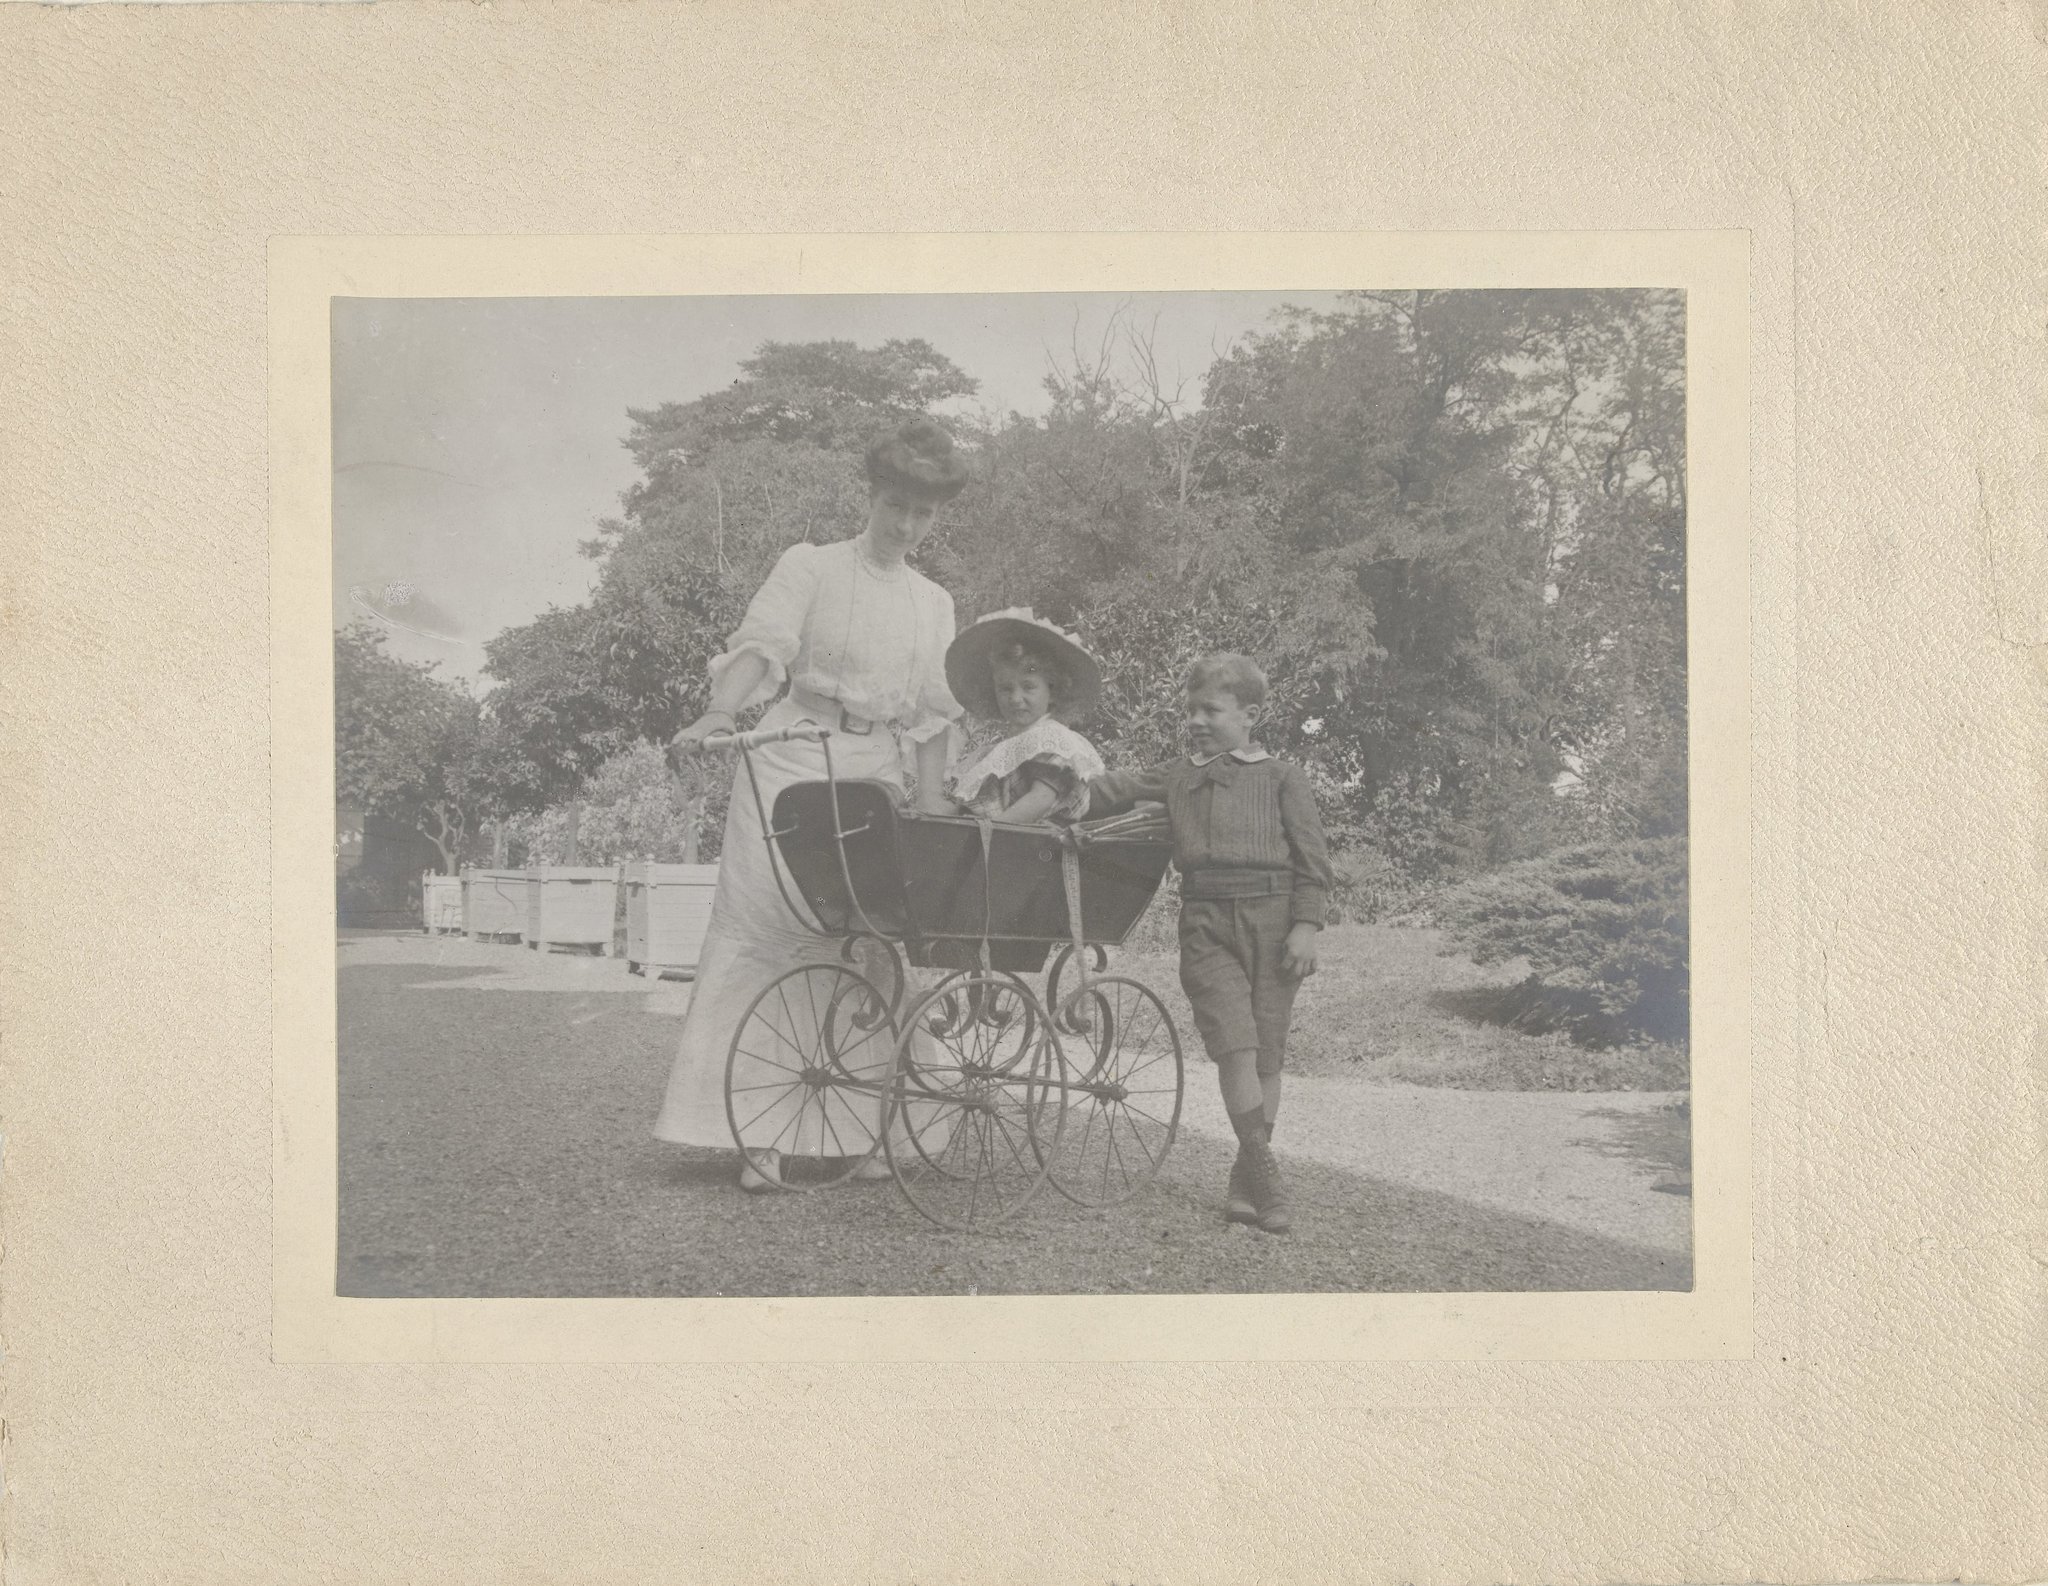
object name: photograph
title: Portret van een vrouw met twee kinderen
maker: Anonymous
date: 1900-1915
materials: photographic support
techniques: gelatin silver print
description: Een van de kinderen zit in een kindrewagen, de ander leunt op d ekinderagen. Het gezelschap staat in een park